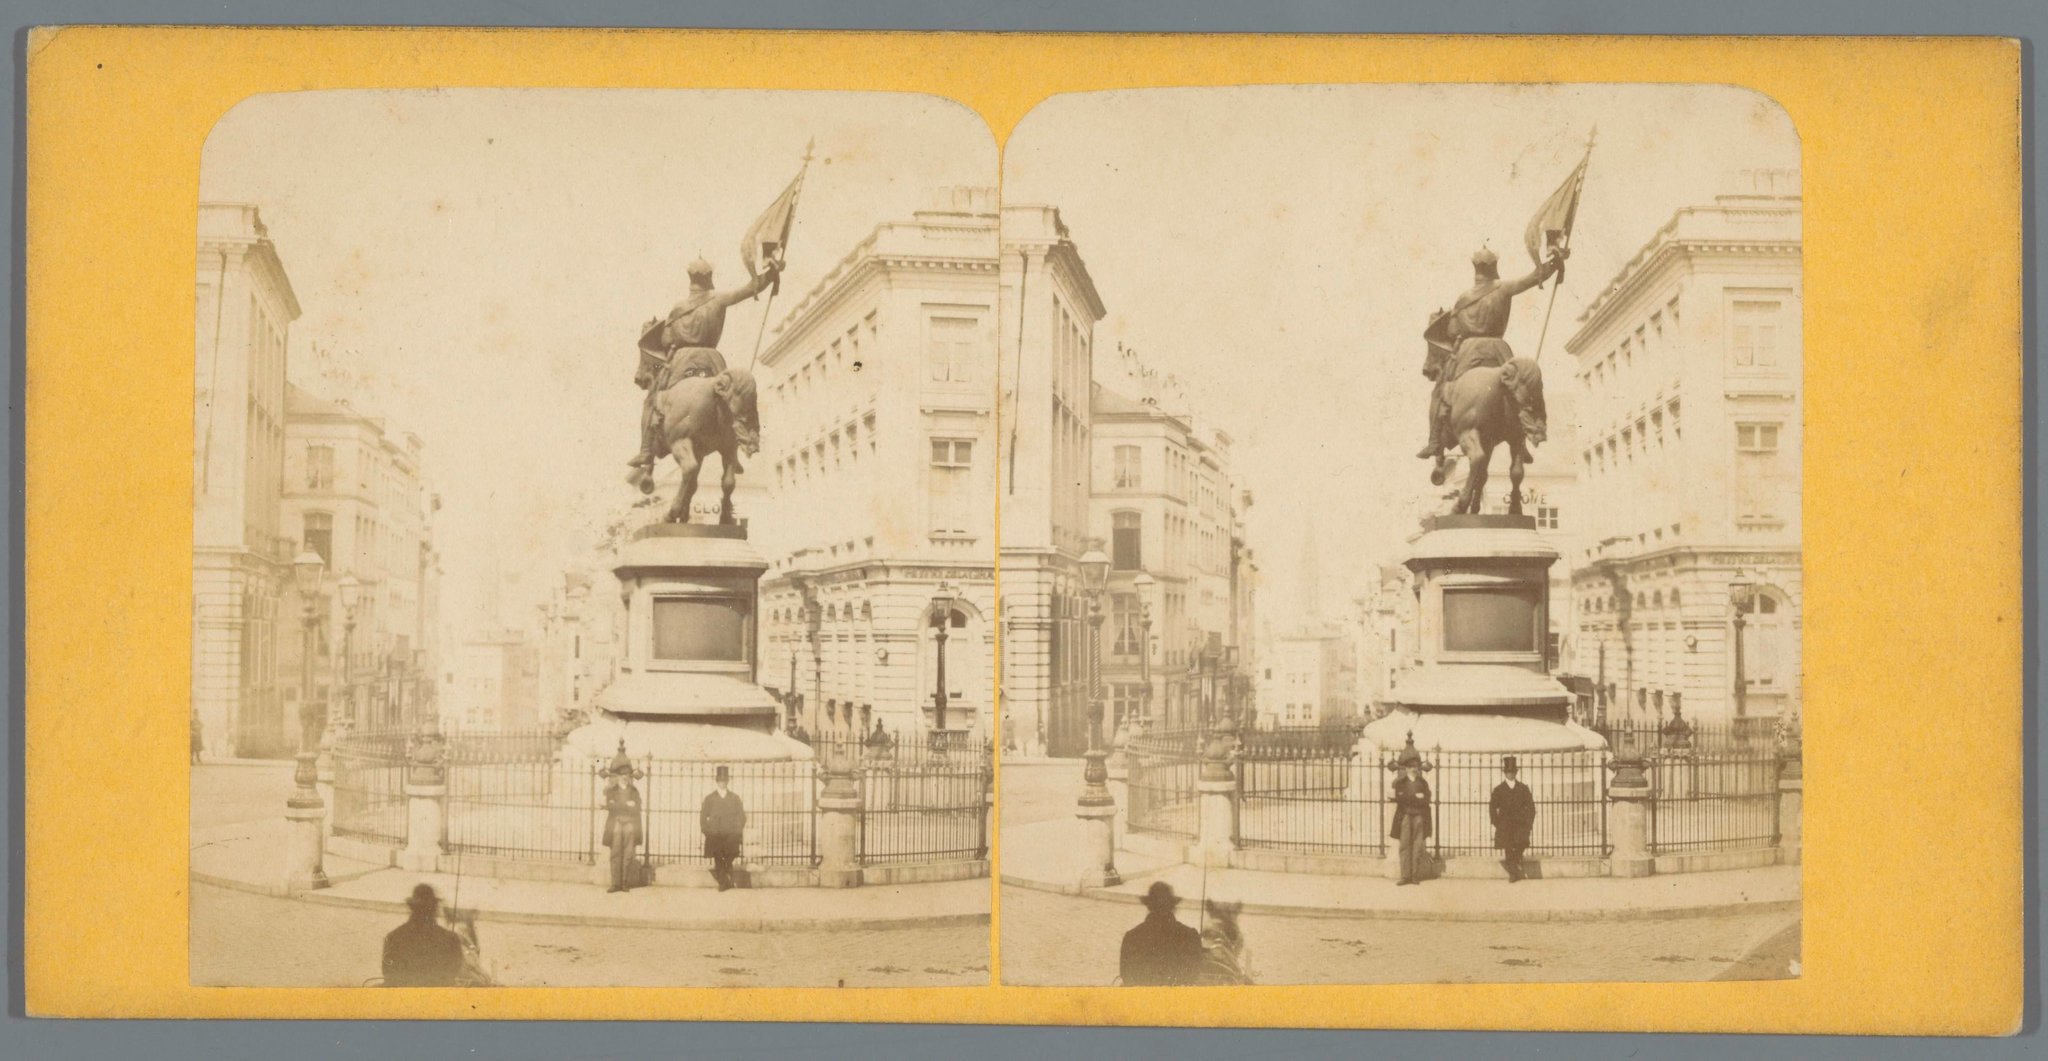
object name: stereograph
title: Belgique, Bruxelles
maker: bt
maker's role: fotograaf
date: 1861-1870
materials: cardboard, paper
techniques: albumen print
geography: brussels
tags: godfrey of bouillon, monument, statue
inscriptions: number: ‘No 5’, retailer's mark: ‘Nolet & Zoon/ Utrecht’, inscription: ‘Belgique. Province de Brabant./ Bruxelles. Pop. 100,000 hoch.’